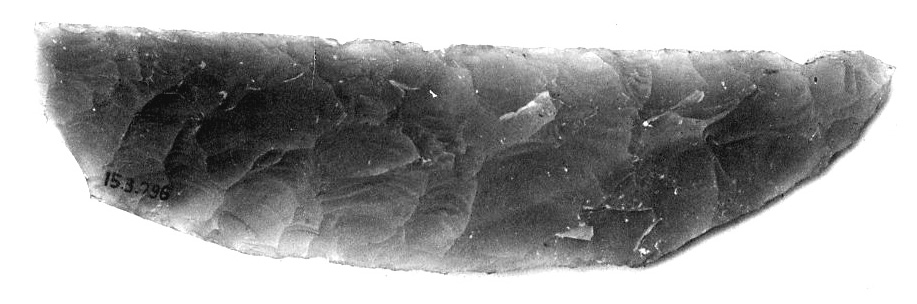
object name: knife, bifacial knife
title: Bifacial Knife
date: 1295-712 BCE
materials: stone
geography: egypt